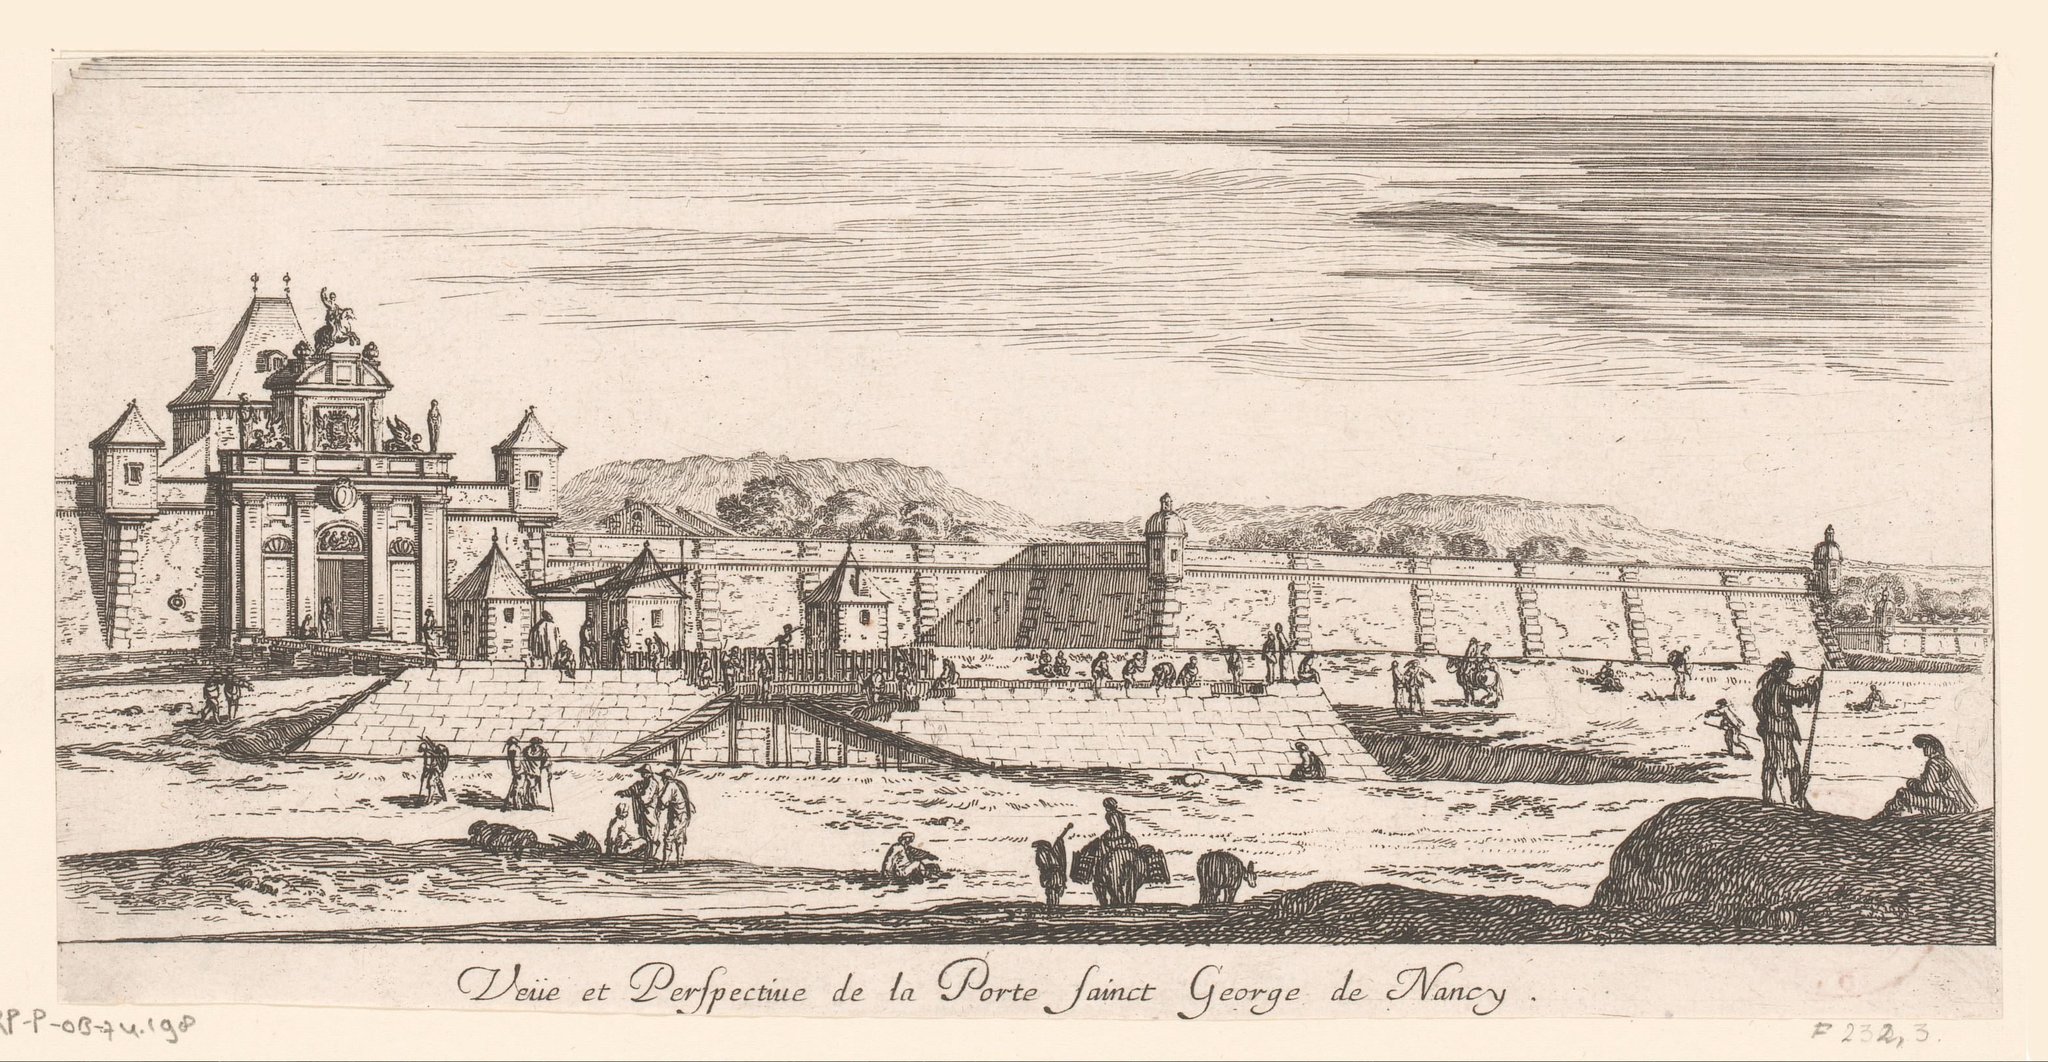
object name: print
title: Veue et Perspective de la Porte sainct George de Nancy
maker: israël silvestre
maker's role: draughtsman, print maker, publisher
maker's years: 1621-1691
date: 1650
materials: paper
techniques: engraving, etching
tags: city-view, and landscape with man-made constructions, city-gate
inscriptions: collector's mark: Lugt 240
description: Prent maakt deel uit van een ongenummerde serie van dertien prenten.